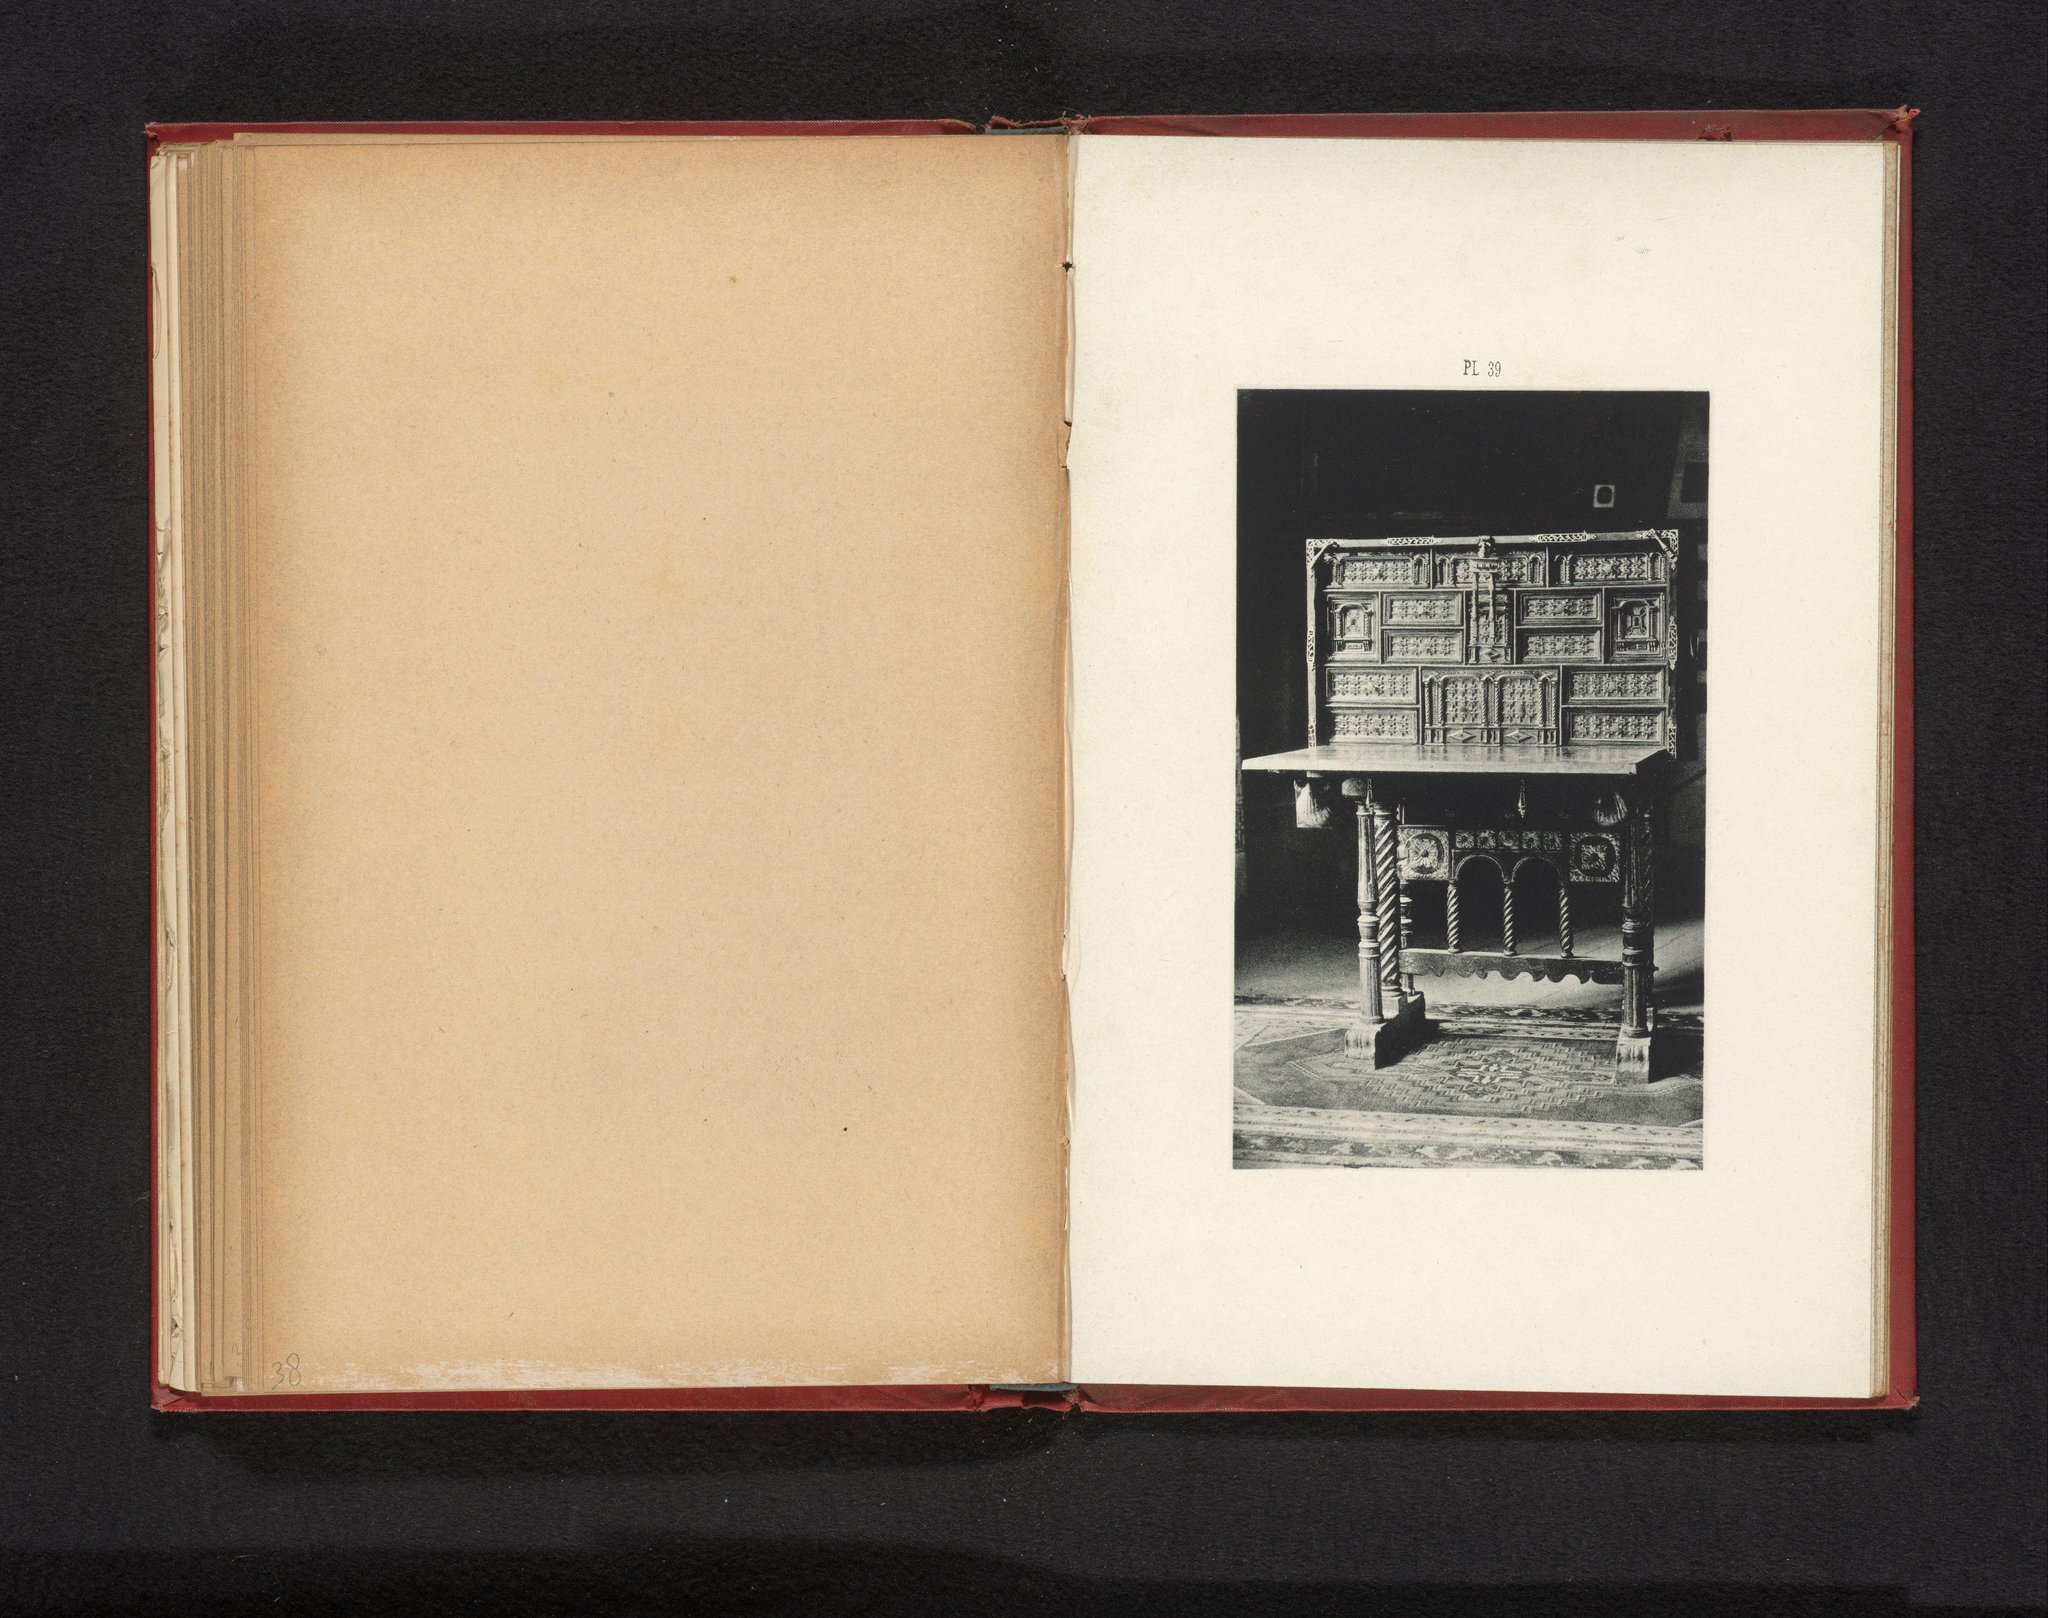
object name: photomechanical print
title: Kabinet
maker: Anonymous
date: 1880-1881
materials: paper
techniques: photograph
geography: barcelona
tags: 'kunstschrank'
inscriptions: number: ‘Pl 39’